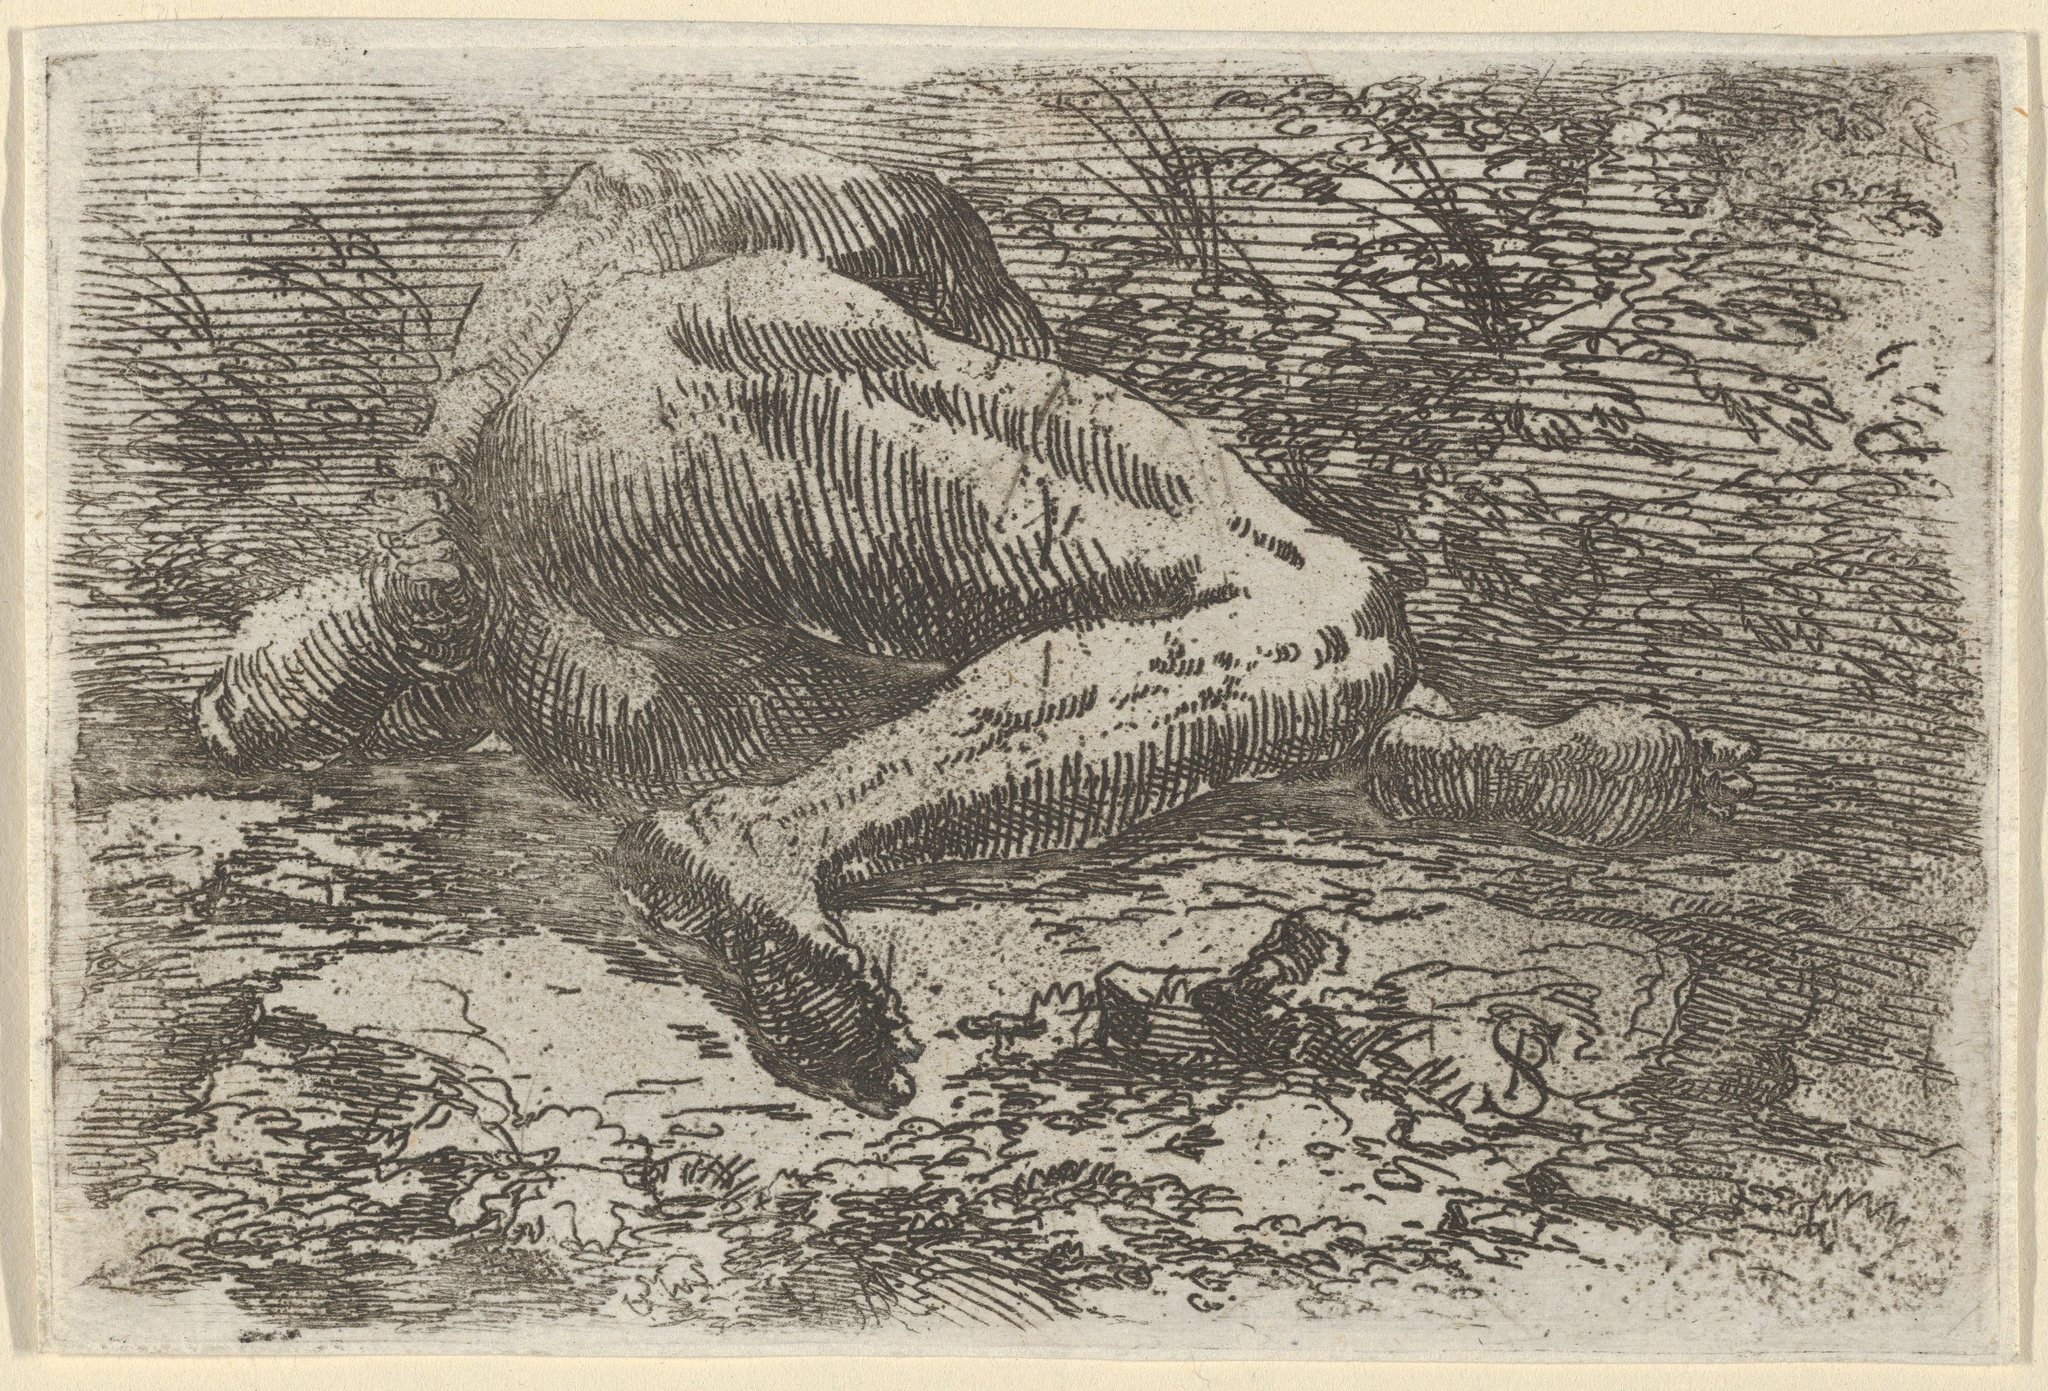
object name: print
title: Male nude lying on his side with his right arm behind his back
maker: salvator rosa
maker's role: artist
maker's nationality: italian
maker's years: 1615-1673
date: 1635-1640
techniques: etching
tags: male nudes,plants